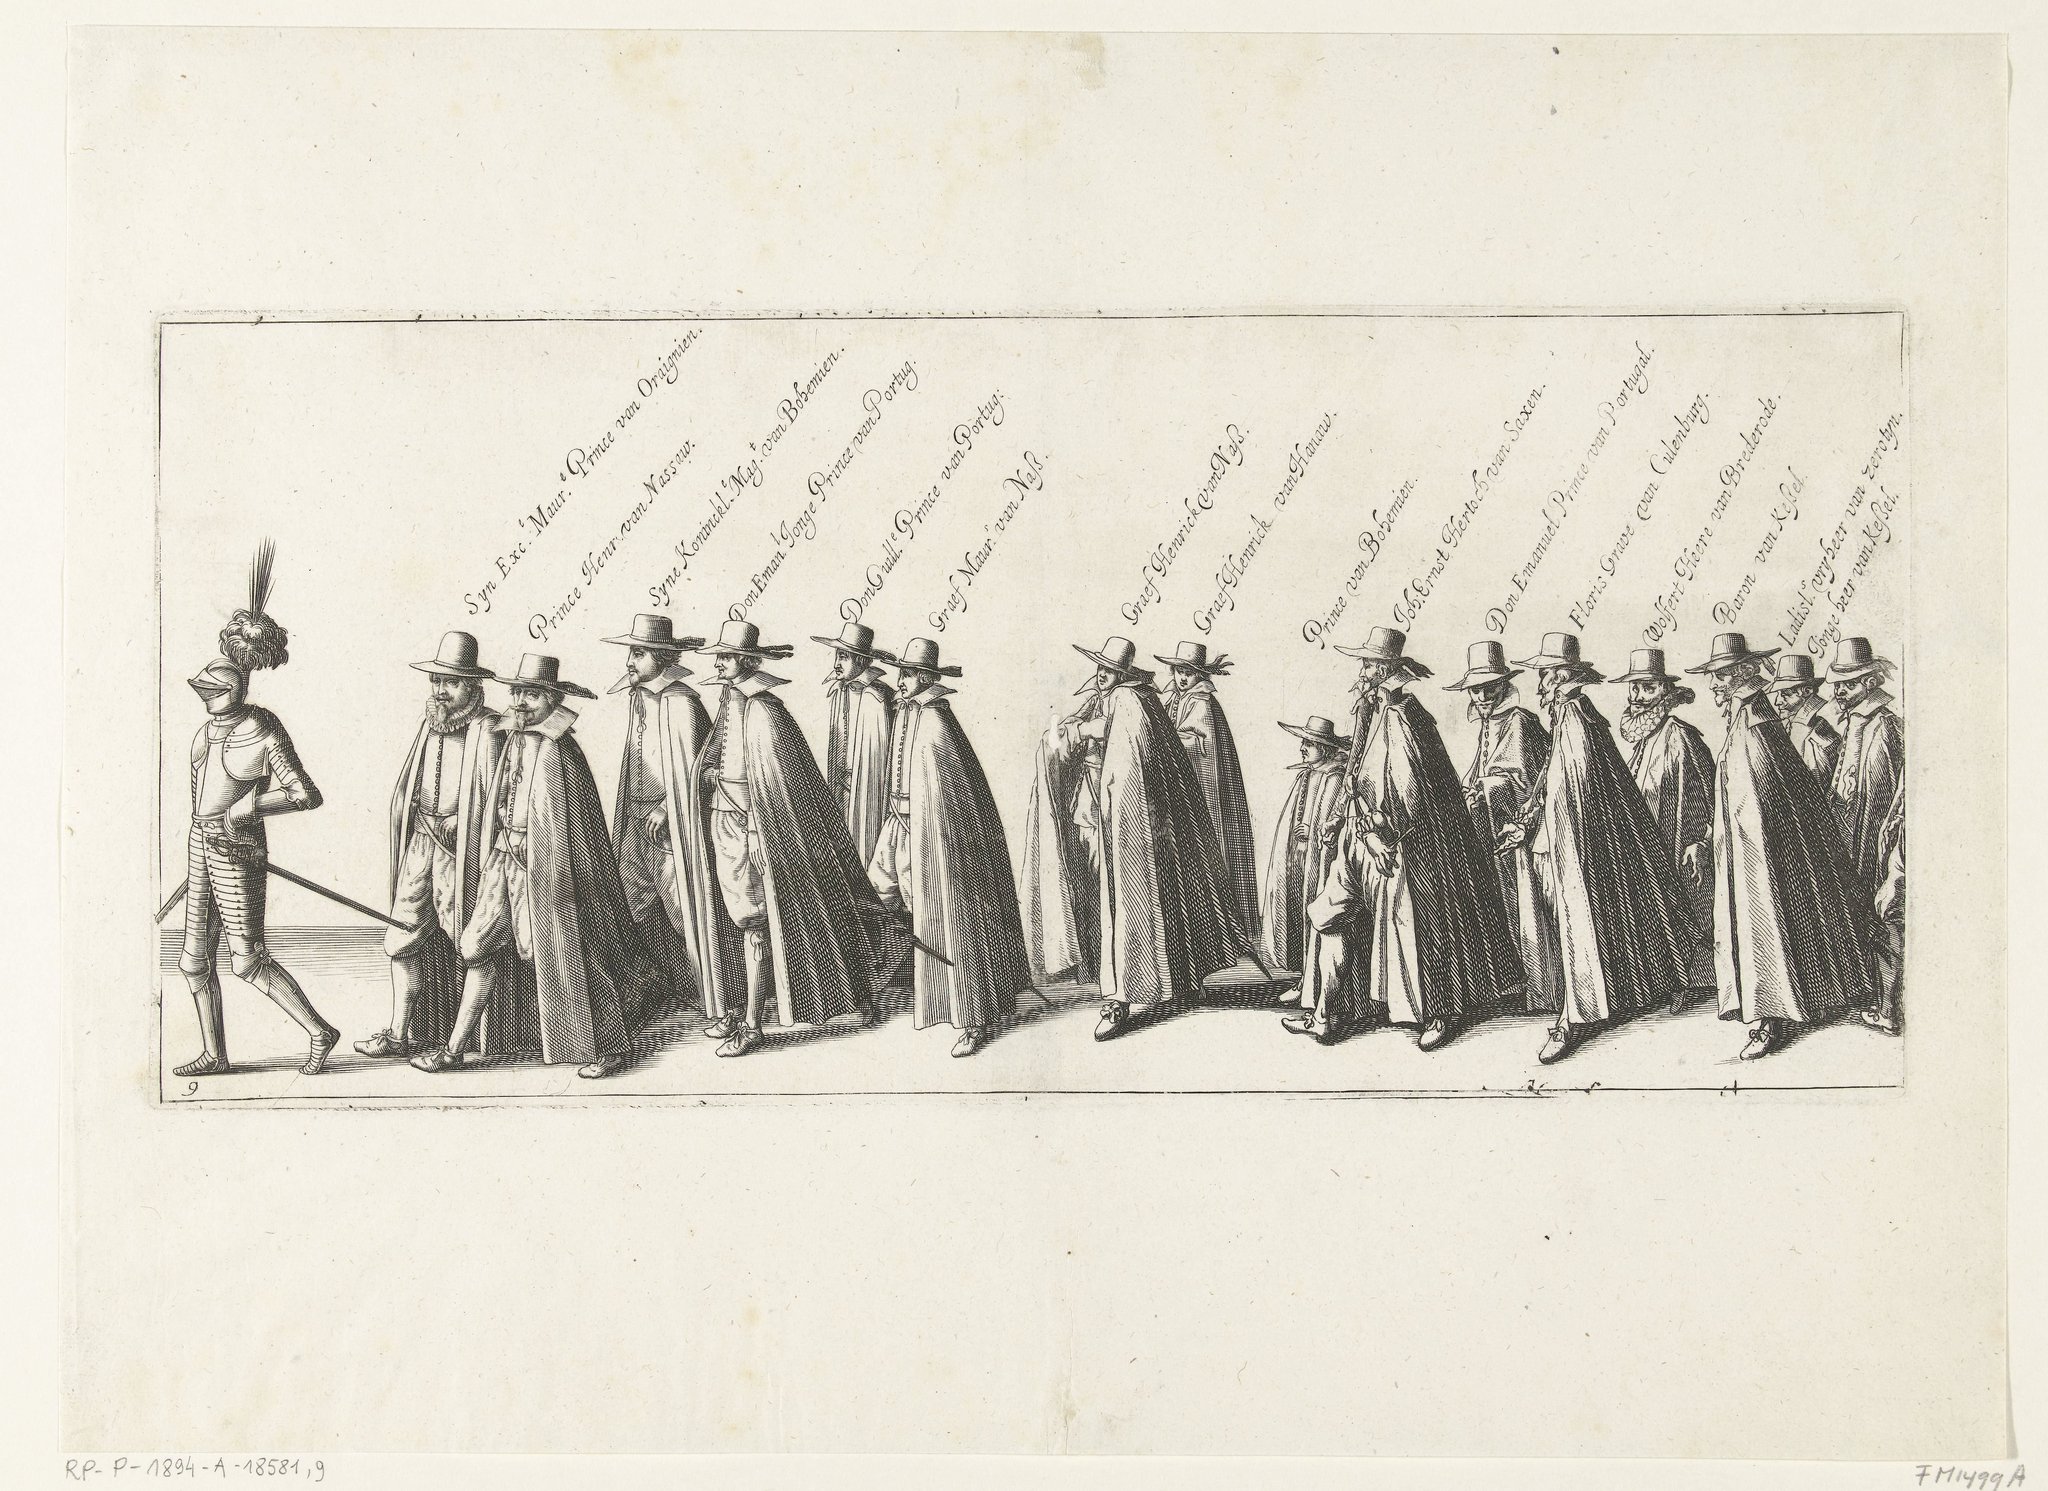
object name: print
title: Begrafenis van Johann Albrecht, graaf van Solms, 1623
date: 1624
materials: paper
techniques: engraving, etching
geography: northern netherlands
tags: cortege, funeral procession, the hague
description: Dit is een originele plaat, dus niet een van de oorspronkelijke platen van de begrafenis van Walraven van Brederode in 1615 (FMH 1305) met wijzigingen in de opschriften met de namen van de personen.